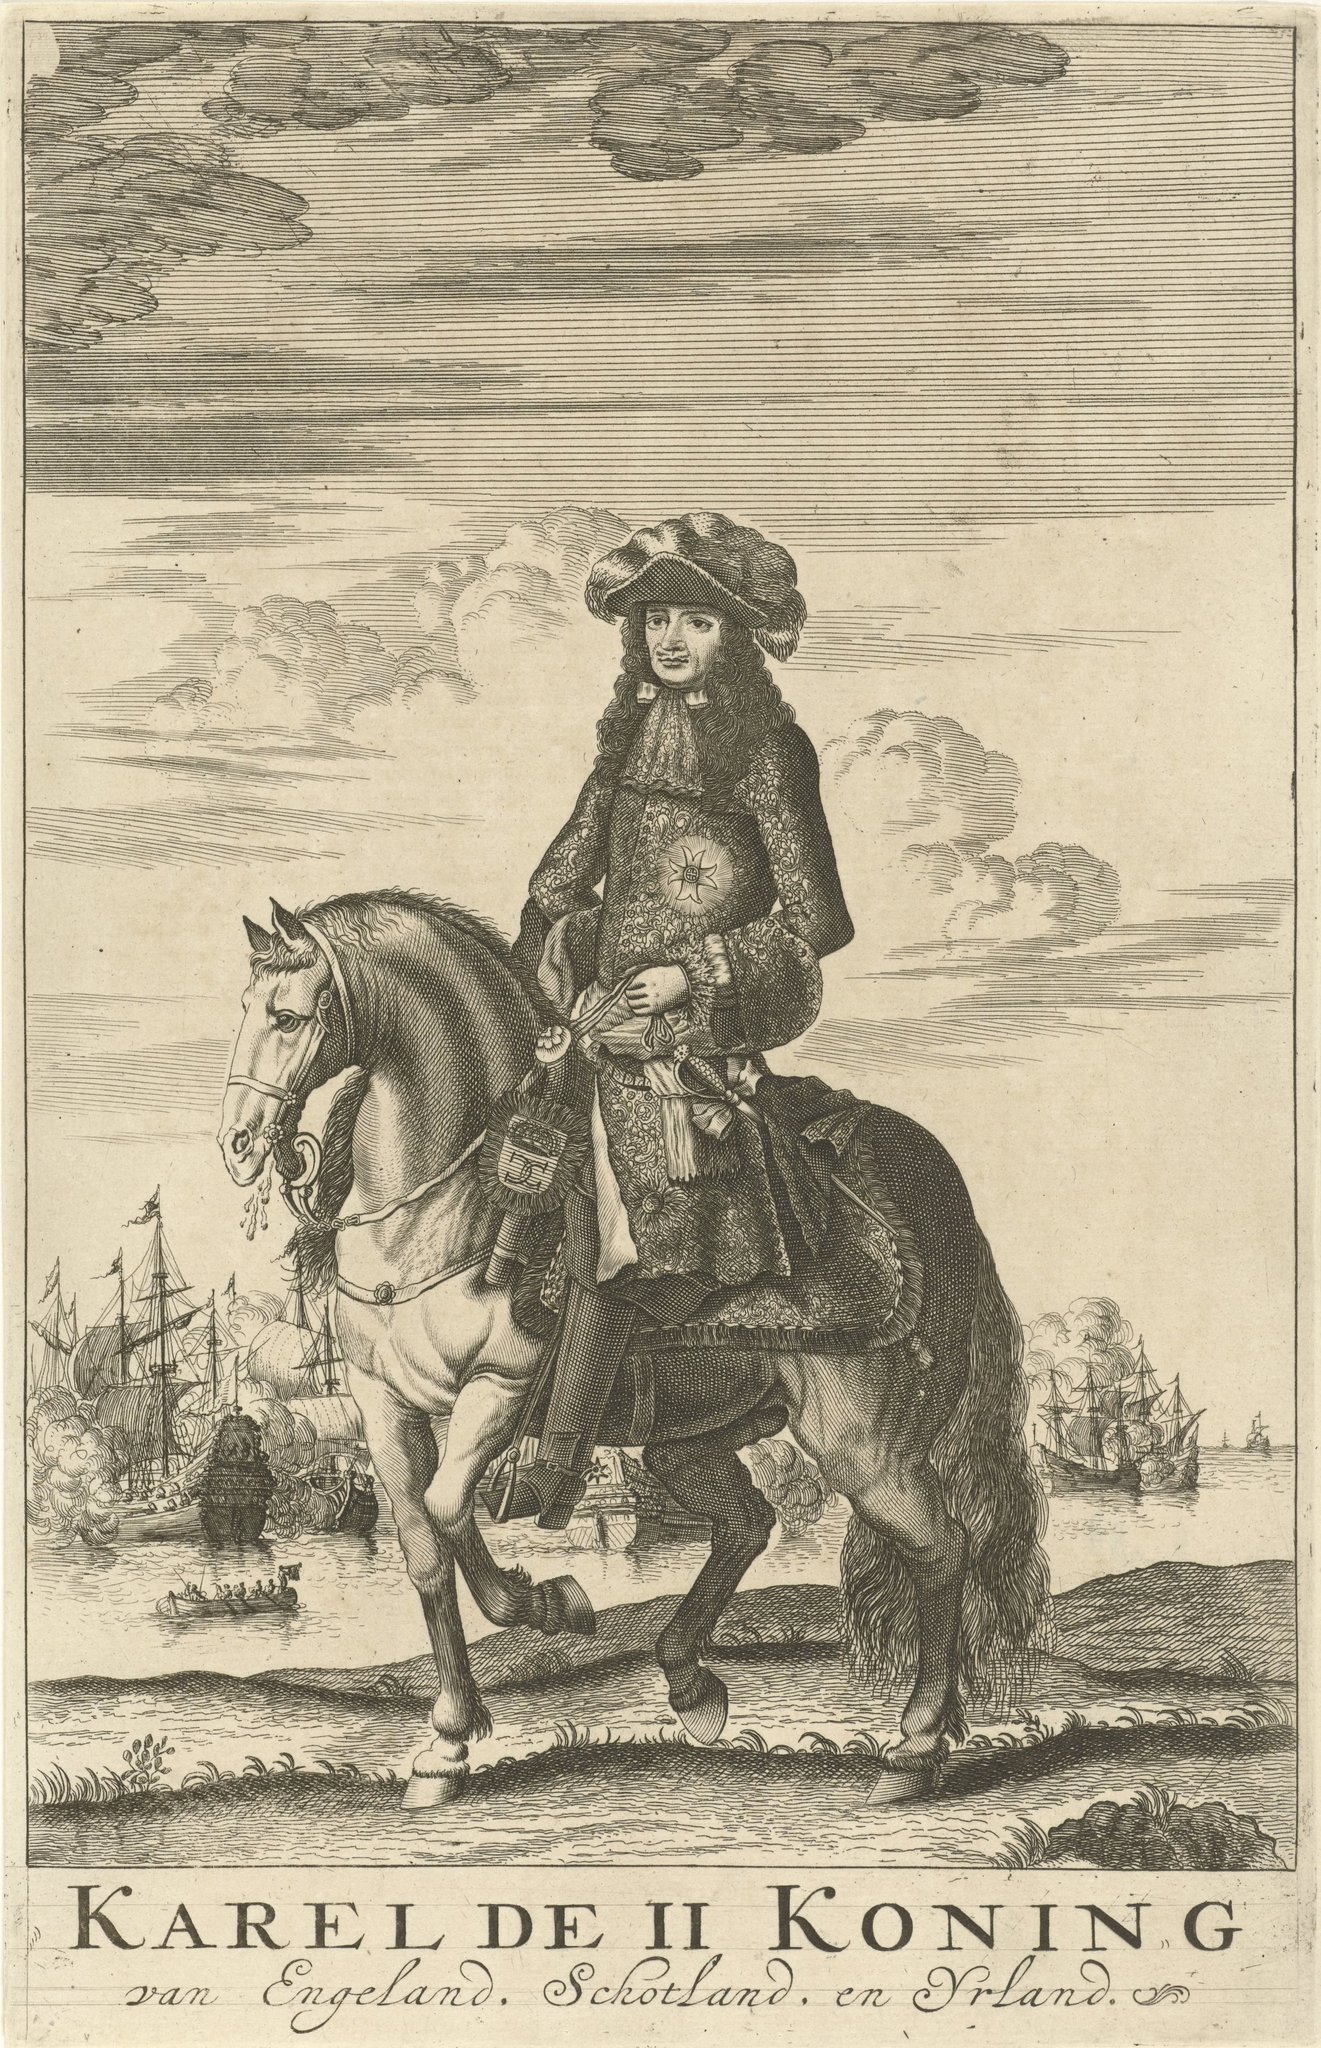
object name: book illustration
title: Karel de II Koning van Engeland, Schotland en Yrland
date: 1685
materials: paper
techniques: engraving, etching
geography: amsterdam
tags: london, karel ii (koning van engeland), equestrian state-portrait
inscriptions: collector's mark: Lugt 2228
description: Illustratie uit: Bos, Lambert van den. Historien onses tyds, behelzende saken van staat en oorlogh, 4 delen. Amsterdam: Jan Bouman (I) en Jan Claesz ten Hoorn, 1685-1699, dl. I (1685), p. 178.